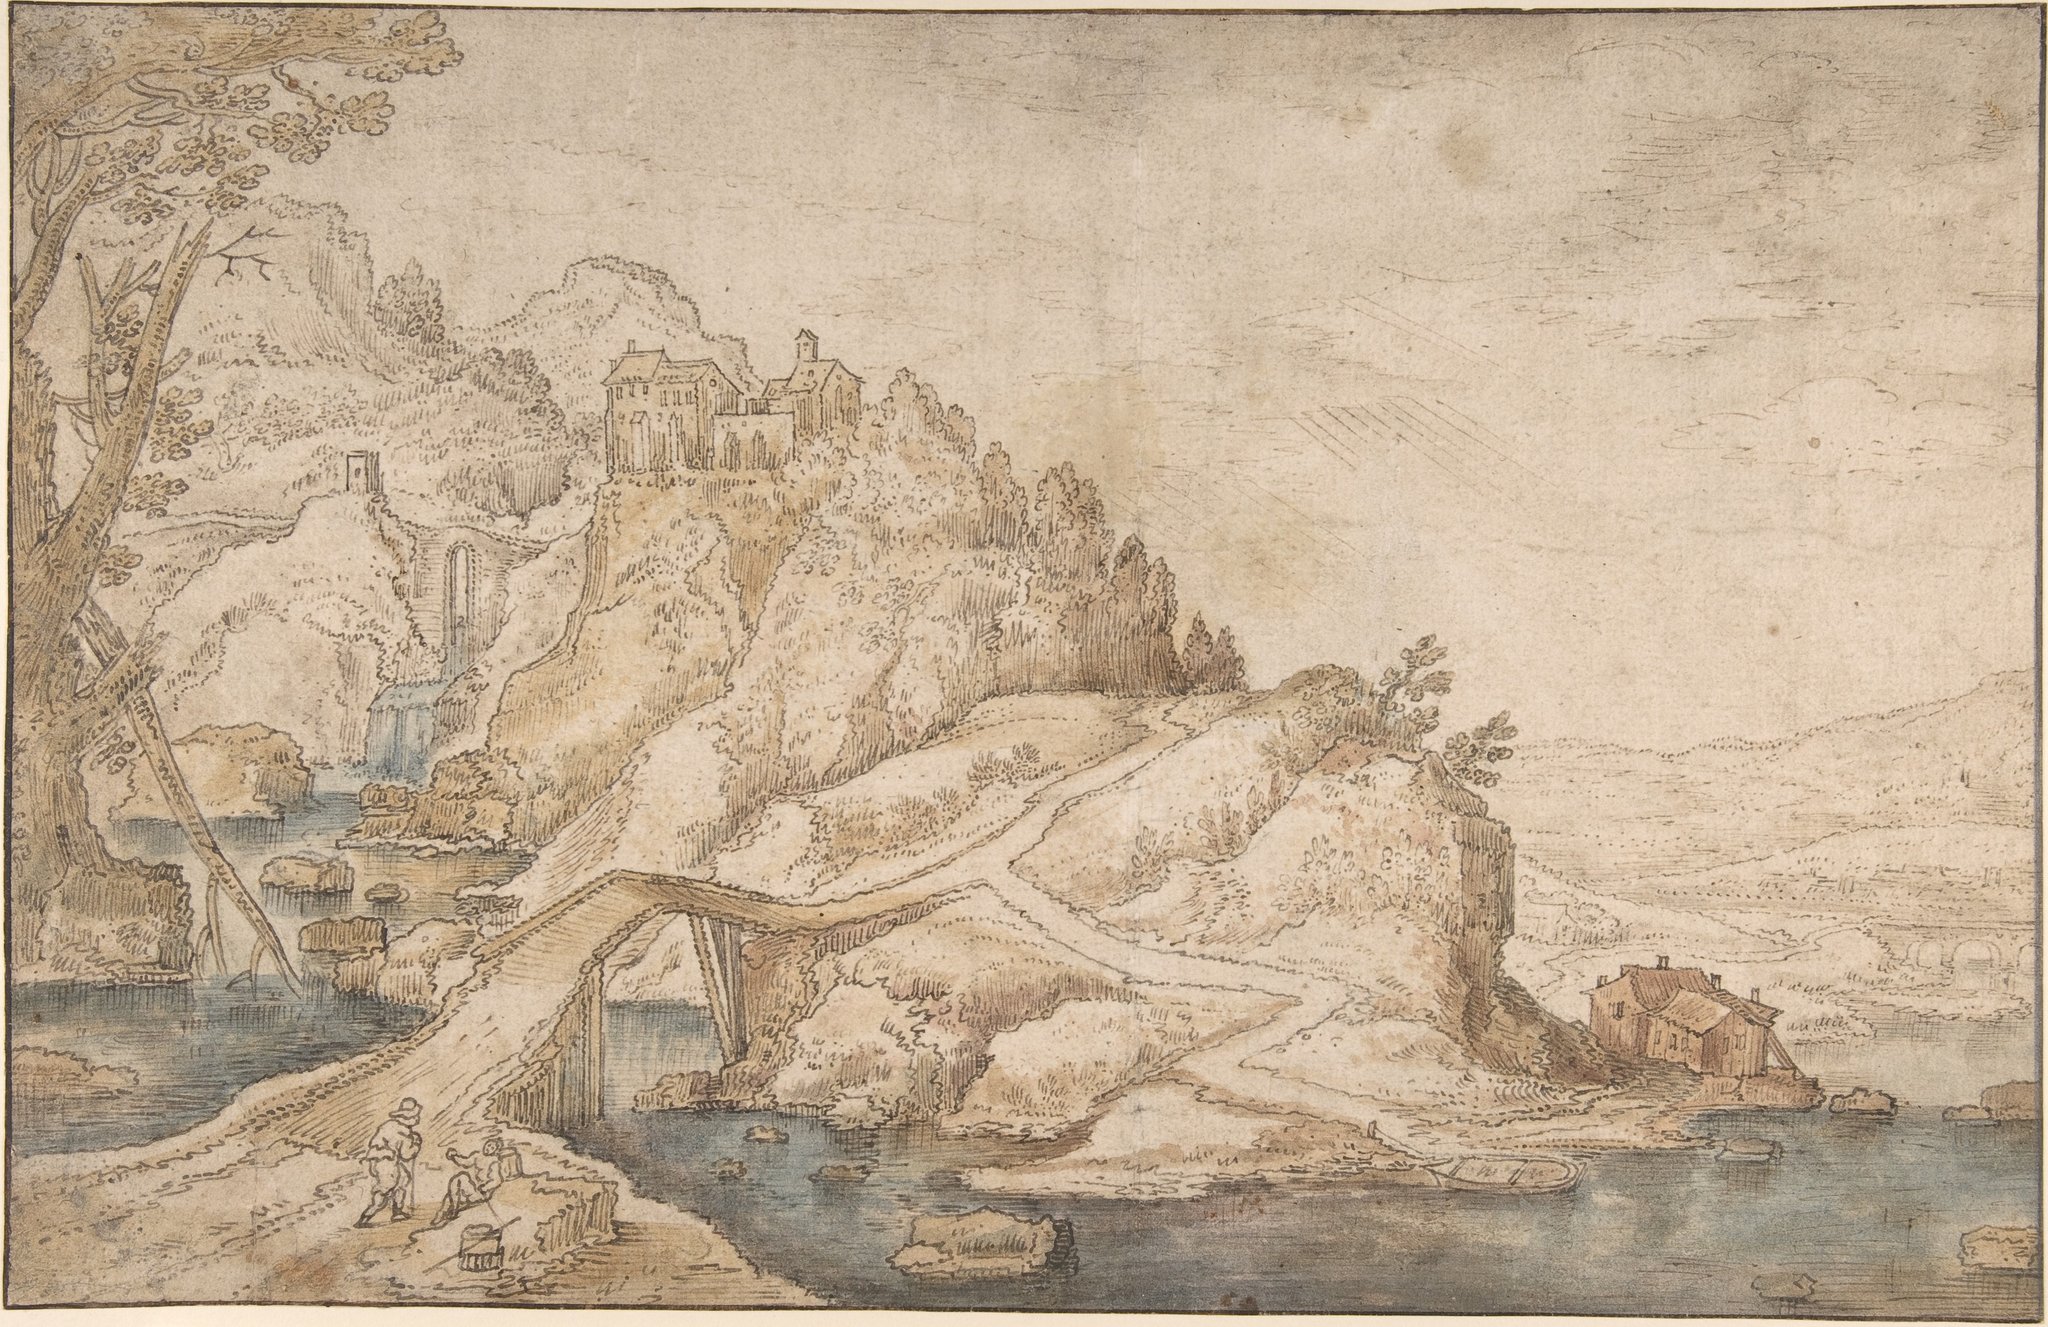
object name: drawing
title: Landscape with a Road Leading Towards a Settlement on a Hill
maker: joos de momper the younger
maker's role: artist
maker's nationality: netherlandish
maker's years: 1564-1635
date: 1567-1666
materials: ink, watercolor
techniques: pen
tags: human figures,houses,bridges,rivers,landscapes